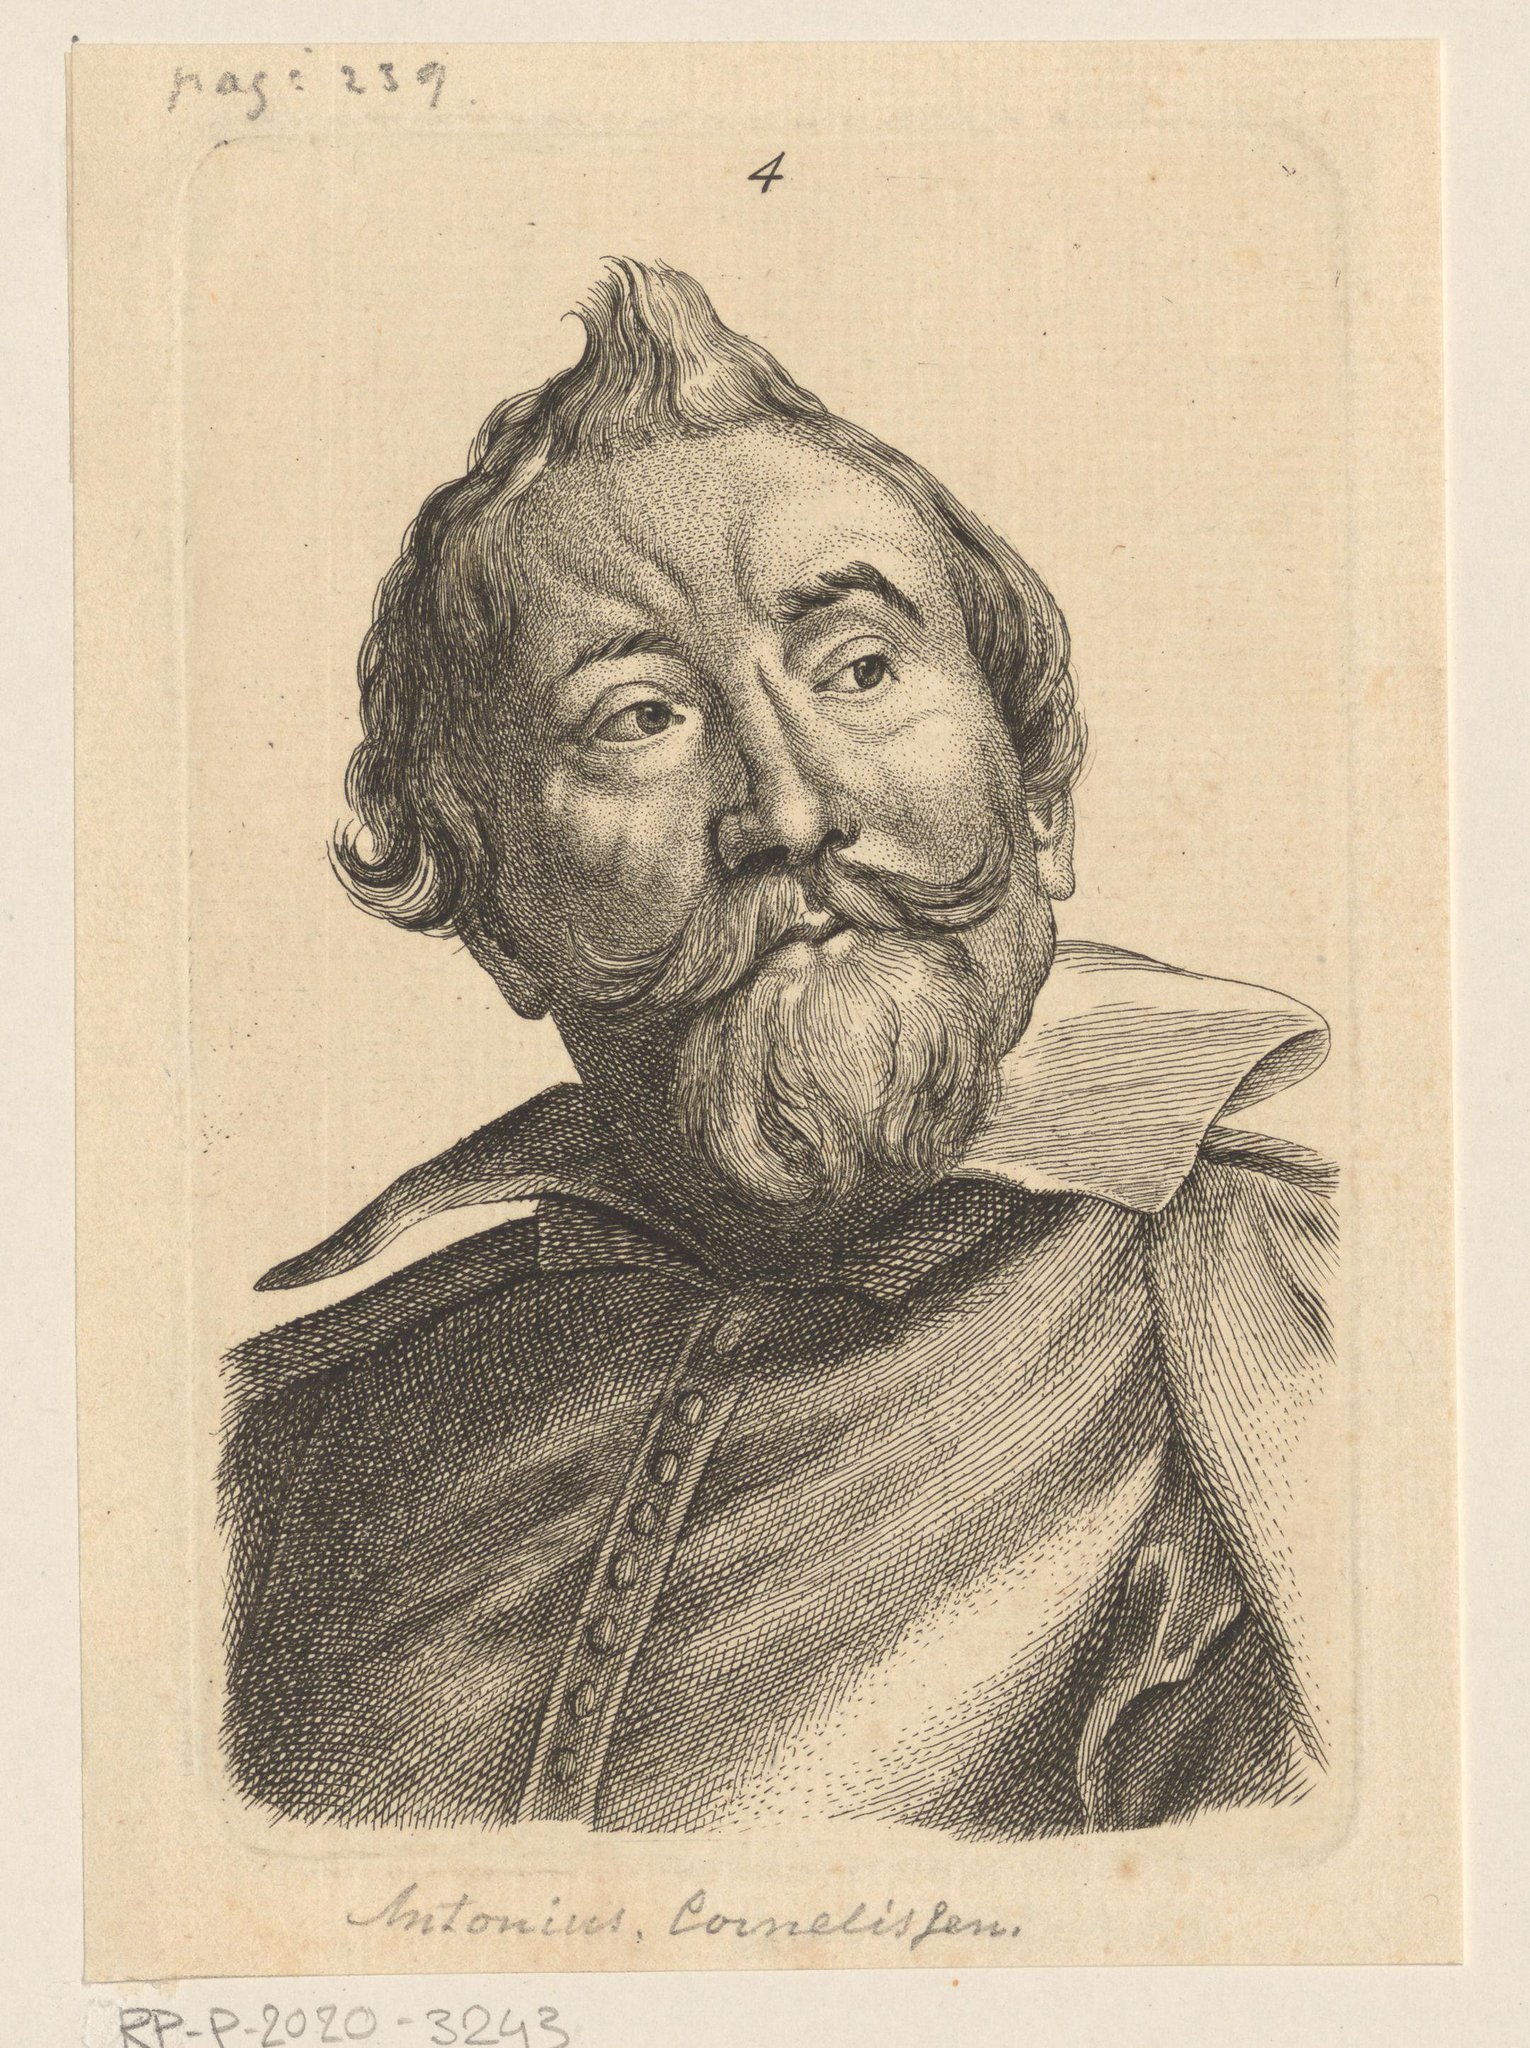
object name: print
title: Portret van Antonius Cornelissen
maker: Anonymous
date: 1700-1799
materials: paper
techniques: etching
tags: historical persons